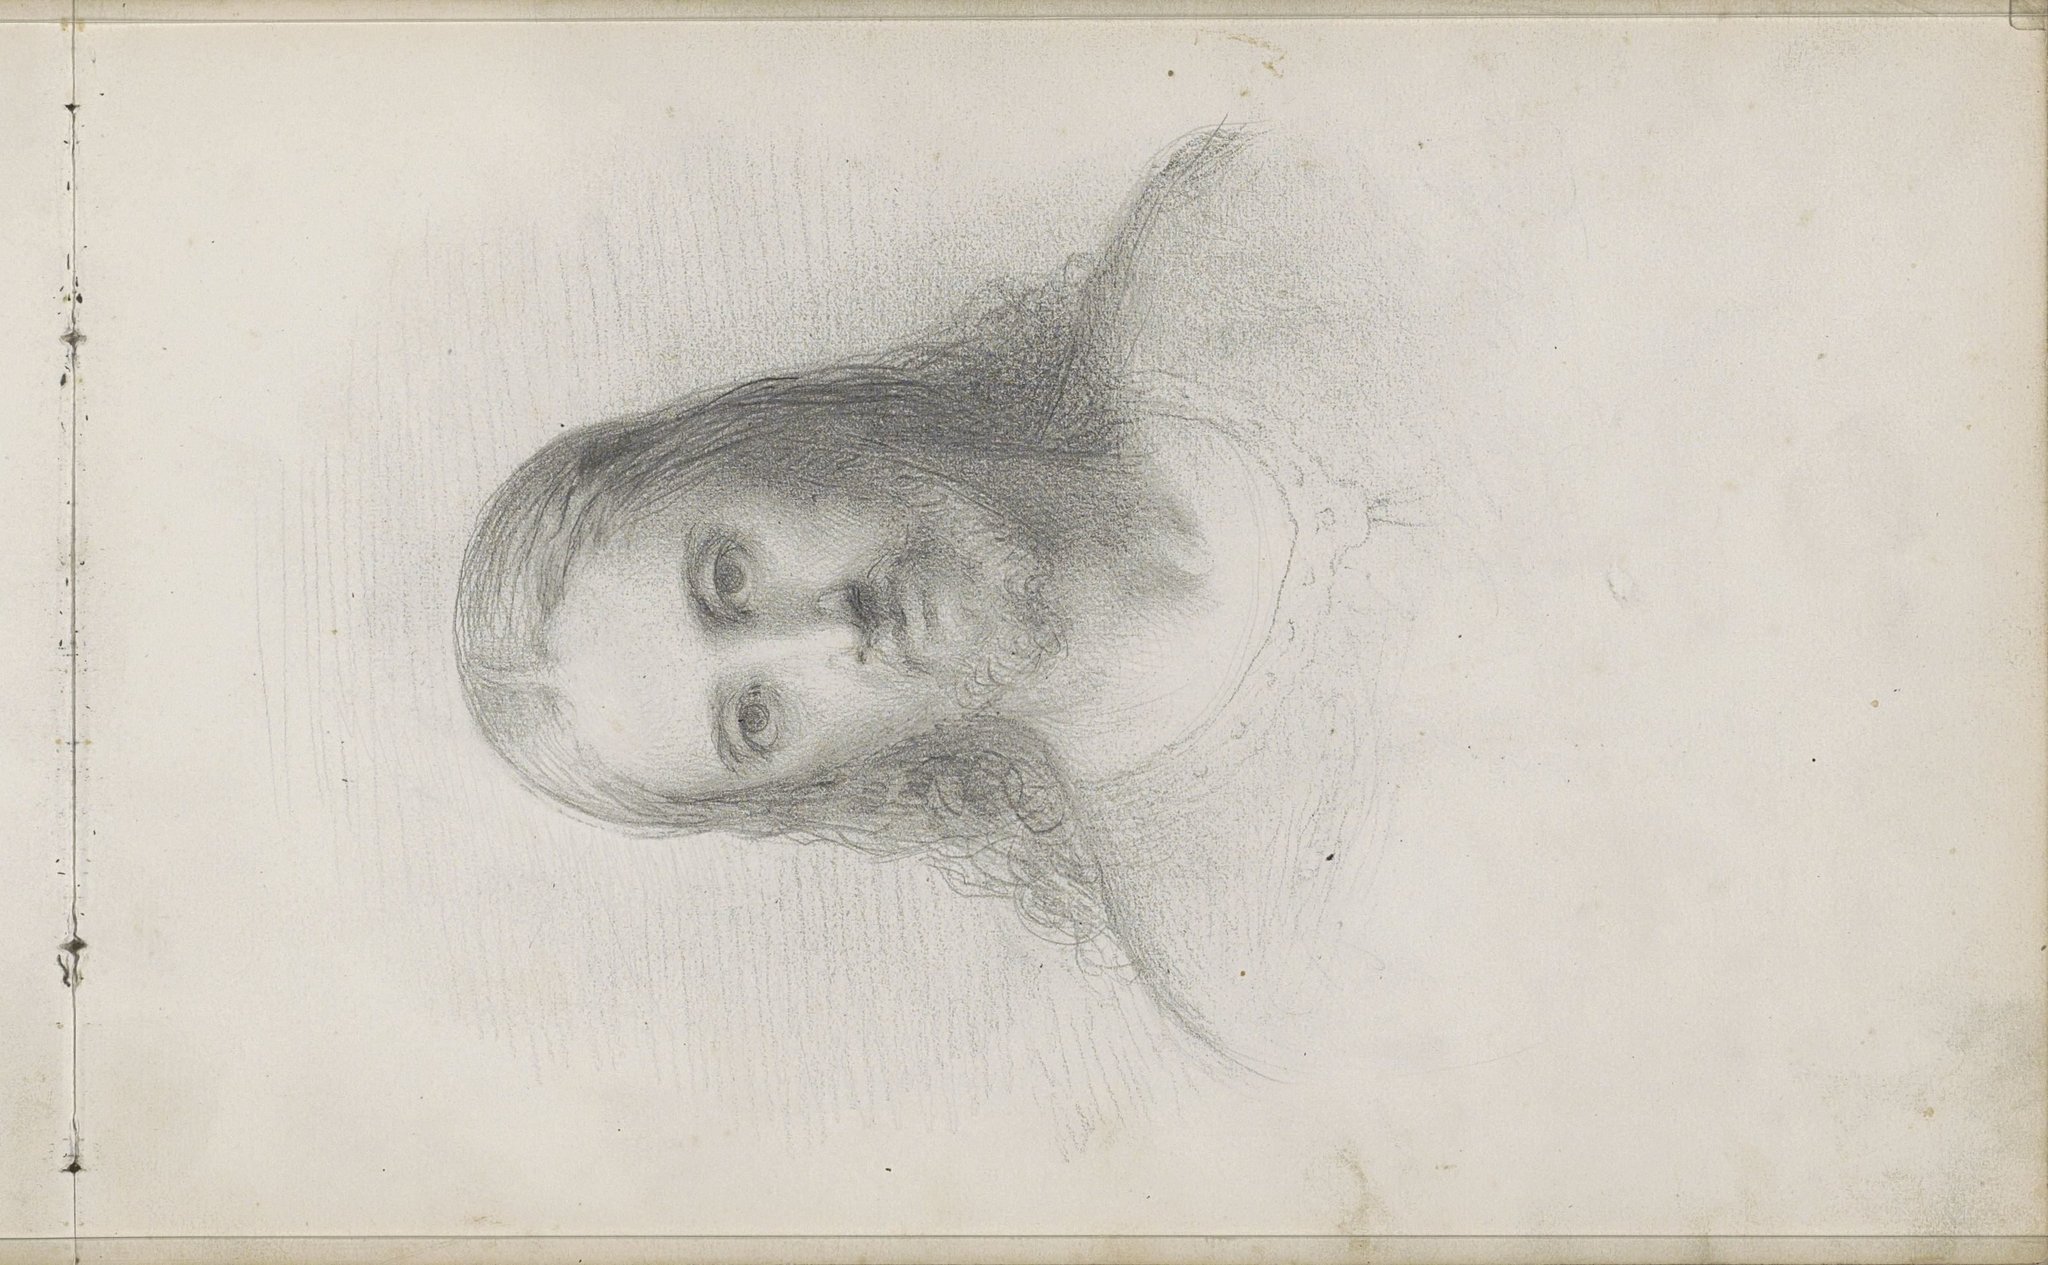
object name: sketchbook leaf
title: Hoofd van Christus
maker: bastiaan de poorter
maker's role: painter, print maker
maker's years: 1813-1880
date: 1858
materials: paper, pencil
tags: 'portraits' of christ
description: Blad 10 recto uit een gecombineerd album amicorum en schetsboek met in totaal 39 bladen.